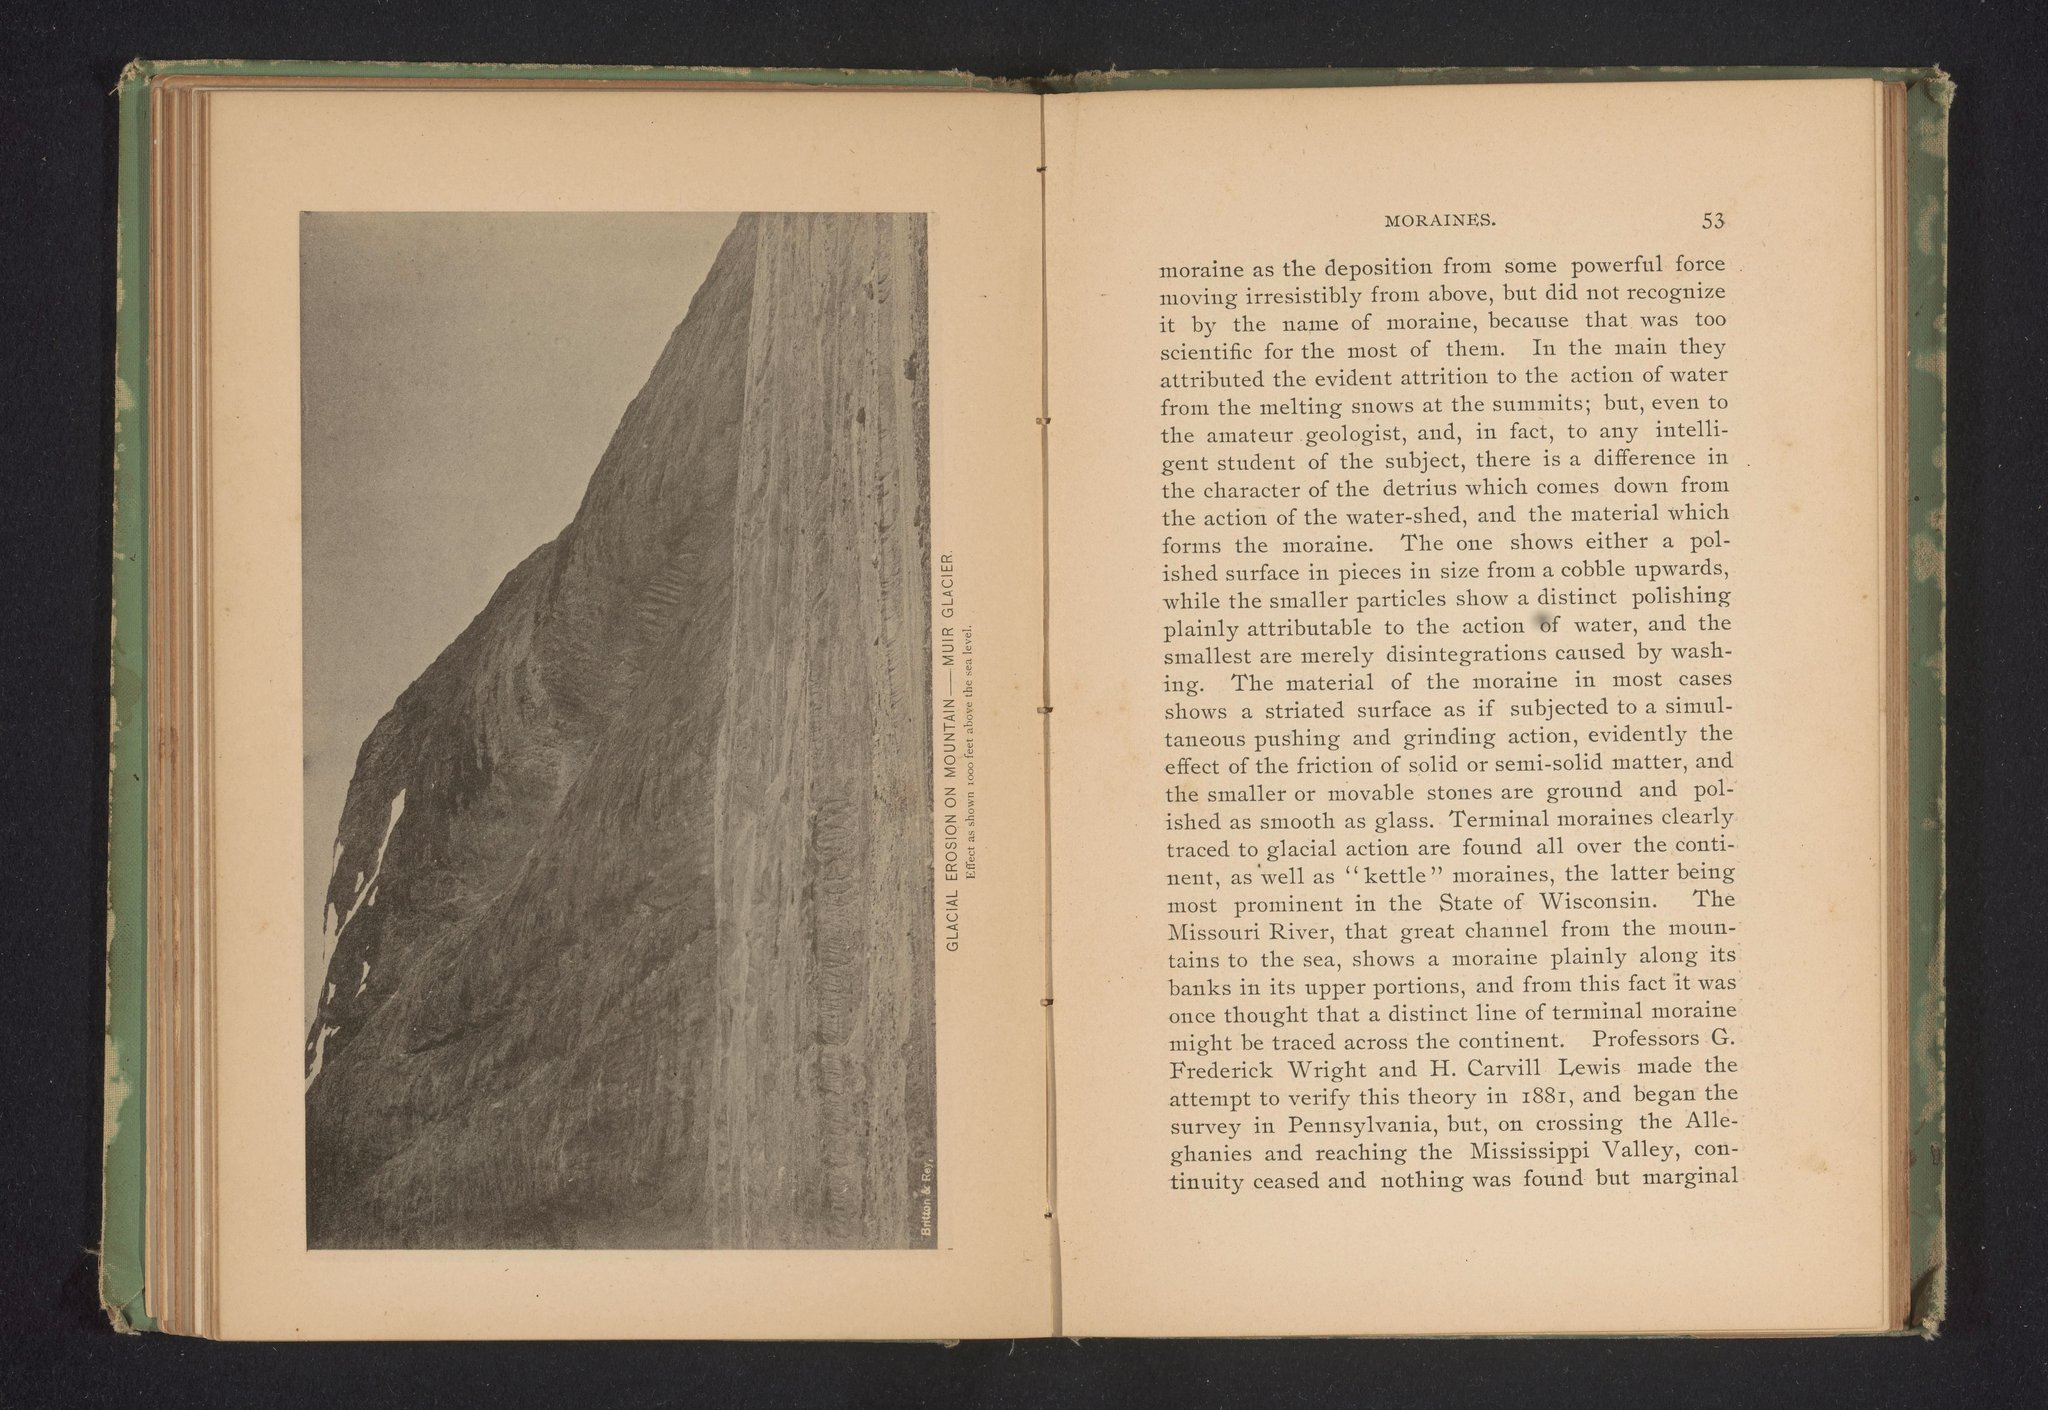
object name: page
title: Glacial erosion on mountain, Muir Glacier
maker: Anonymous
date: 1885-1890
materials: paper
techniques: photograph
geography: new york city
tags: glacier, mountains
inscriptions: inscription: ‘Effect as shown 1000 feet above the sea level.’, inscription: ‘Britton & Rey’